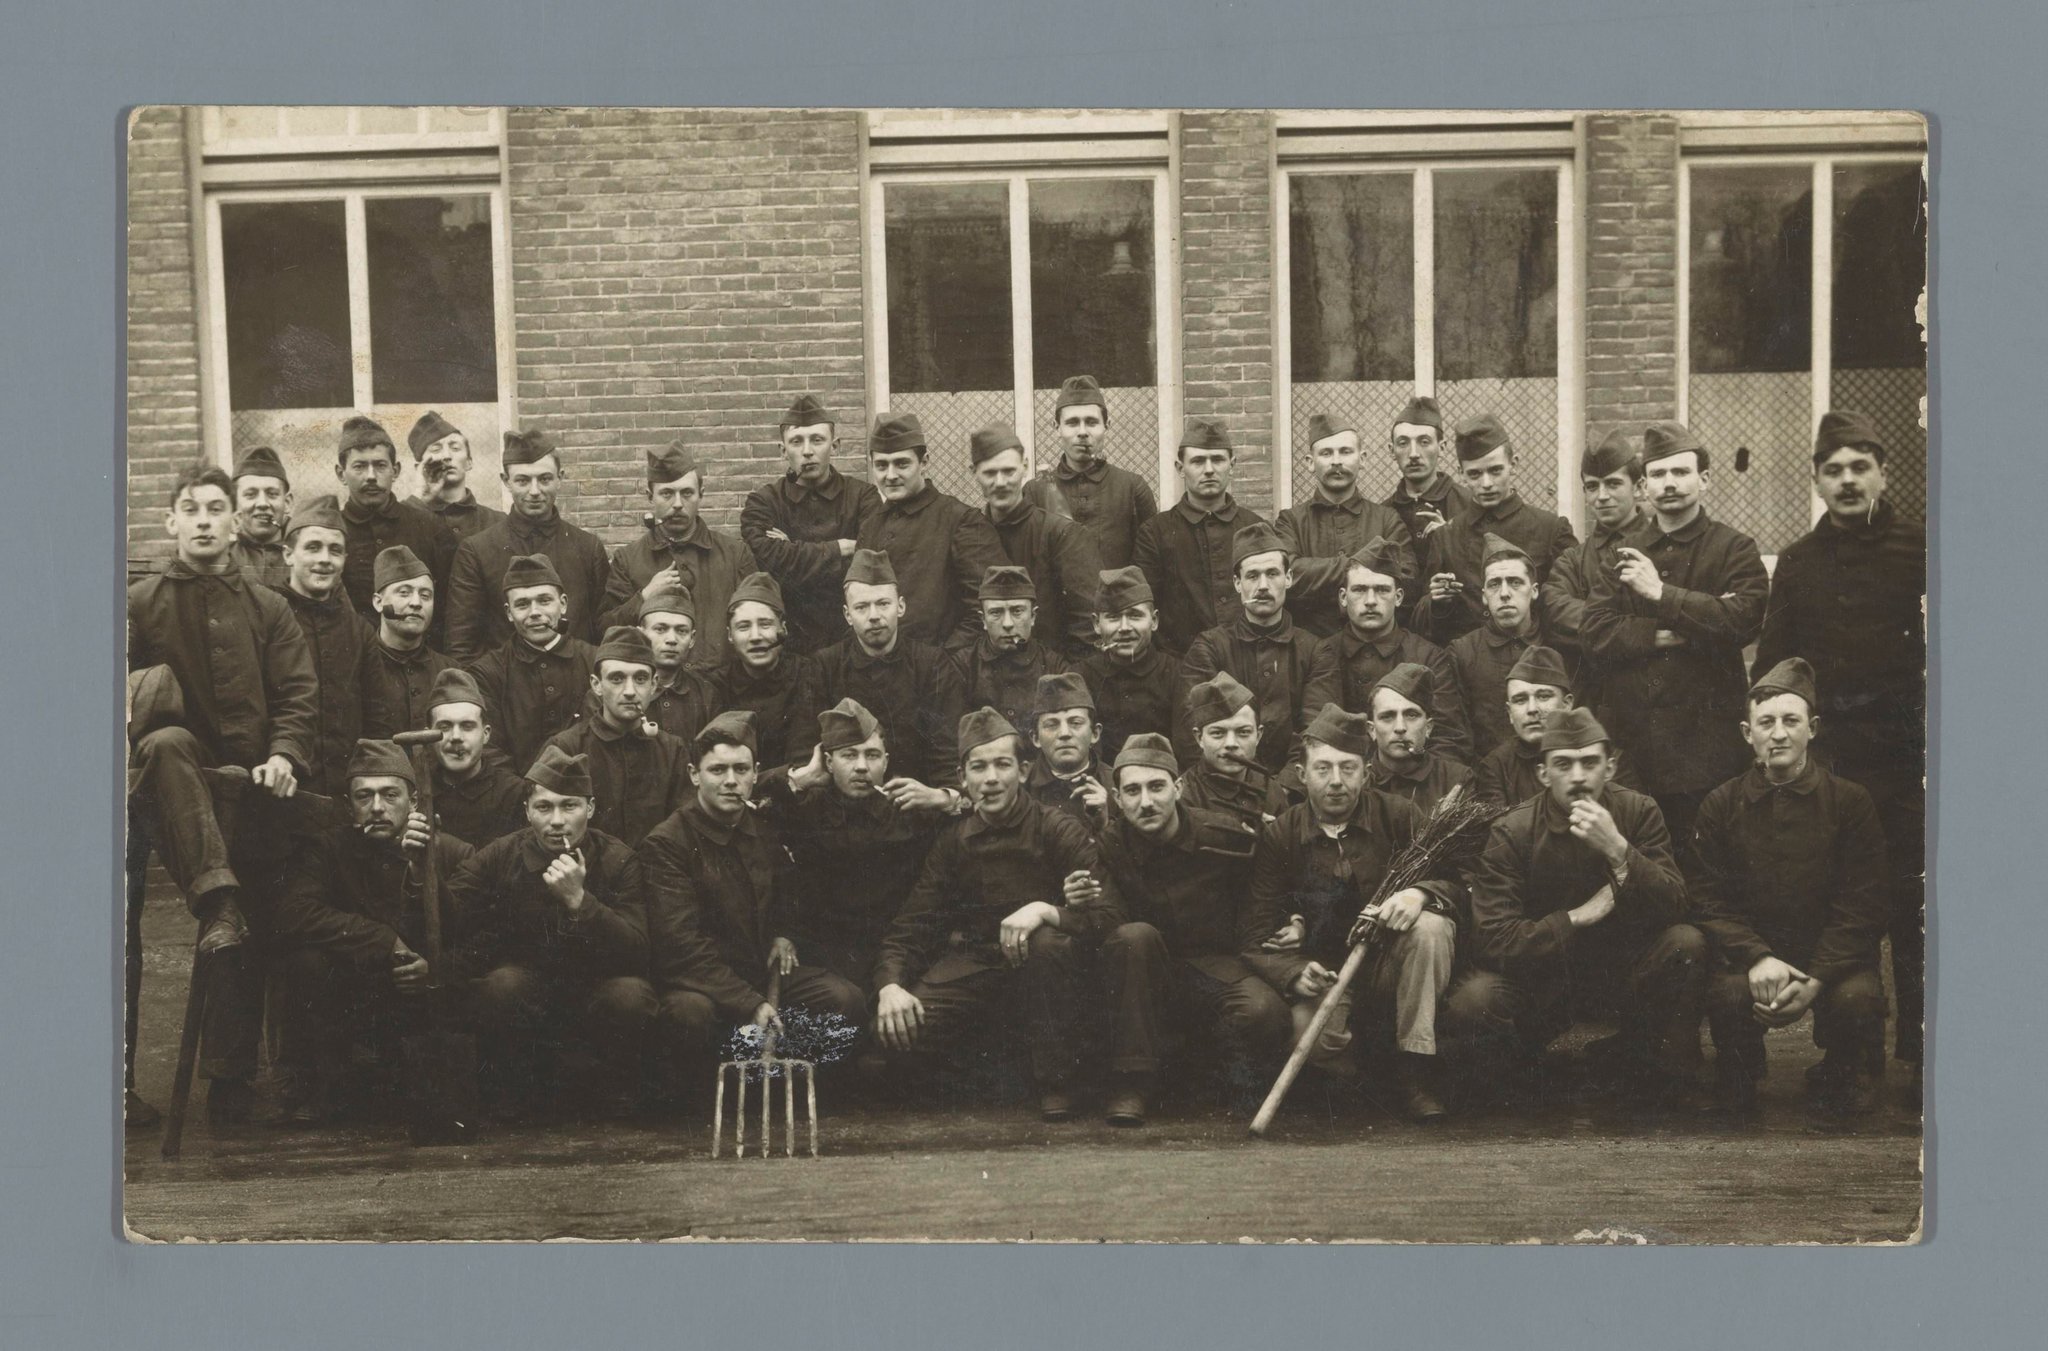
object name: ansichtkaart, prentbriefkaart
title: Groepsportret van soldaten in uniform voor een gebouw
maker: Anonymous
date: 1910-1918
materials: photographic support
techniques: gelatin silver print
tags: private soldier, anonymous historical persons portrayed in a group, in a group-portrait